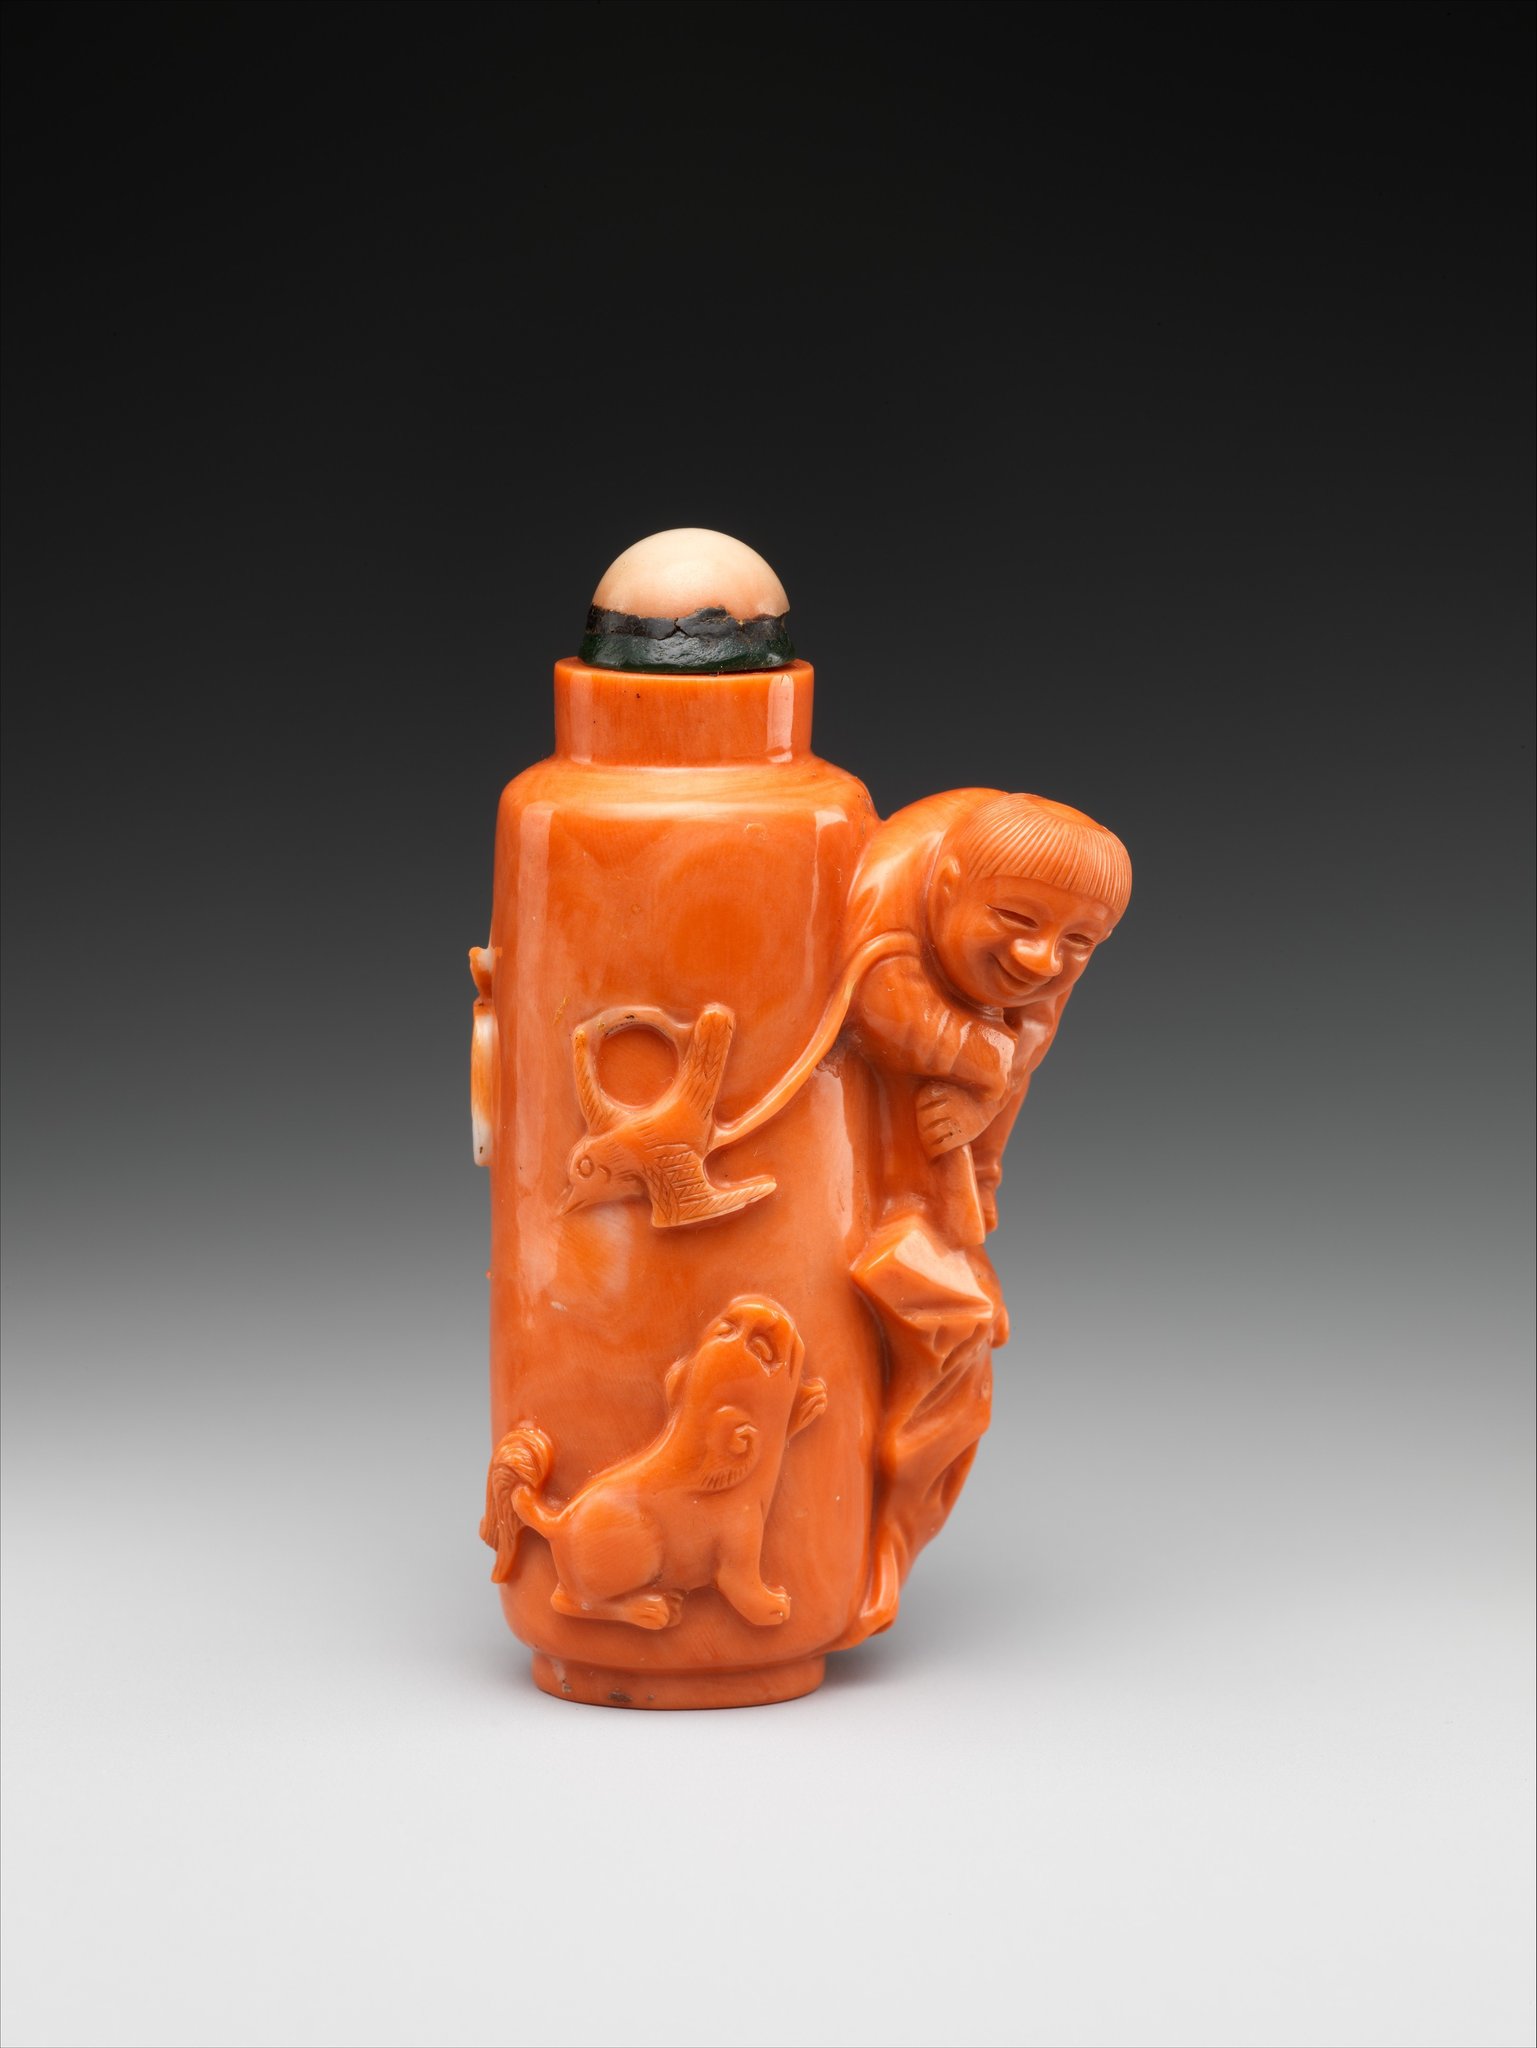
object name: snuff bottle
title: Snuff bottle with boy flying a bird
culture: chinese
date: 1736-1795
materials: coral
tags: animals,birds,boys